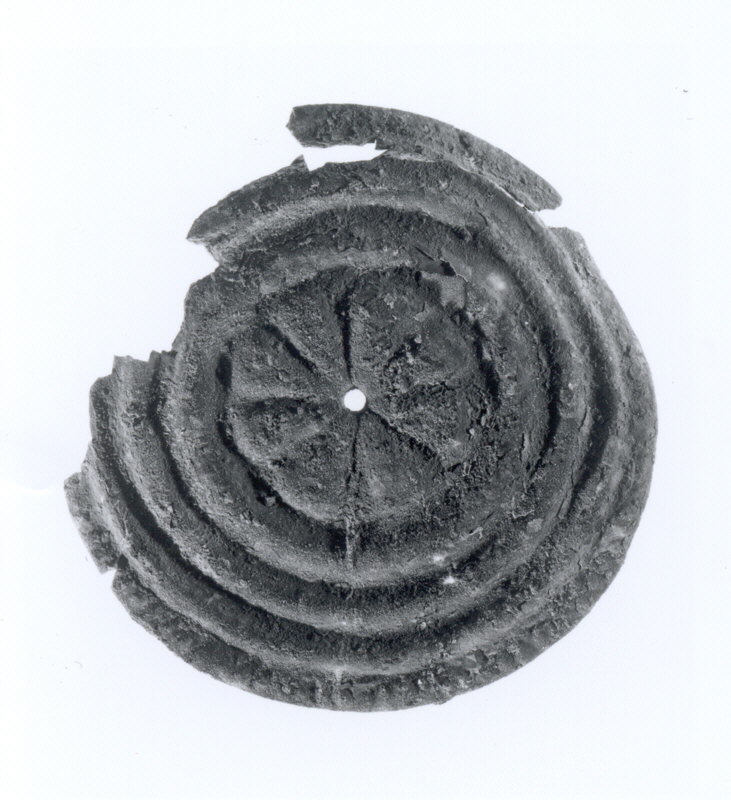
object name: umbo or stud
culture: iranian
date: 900-801 BCE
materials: bronze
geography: iran